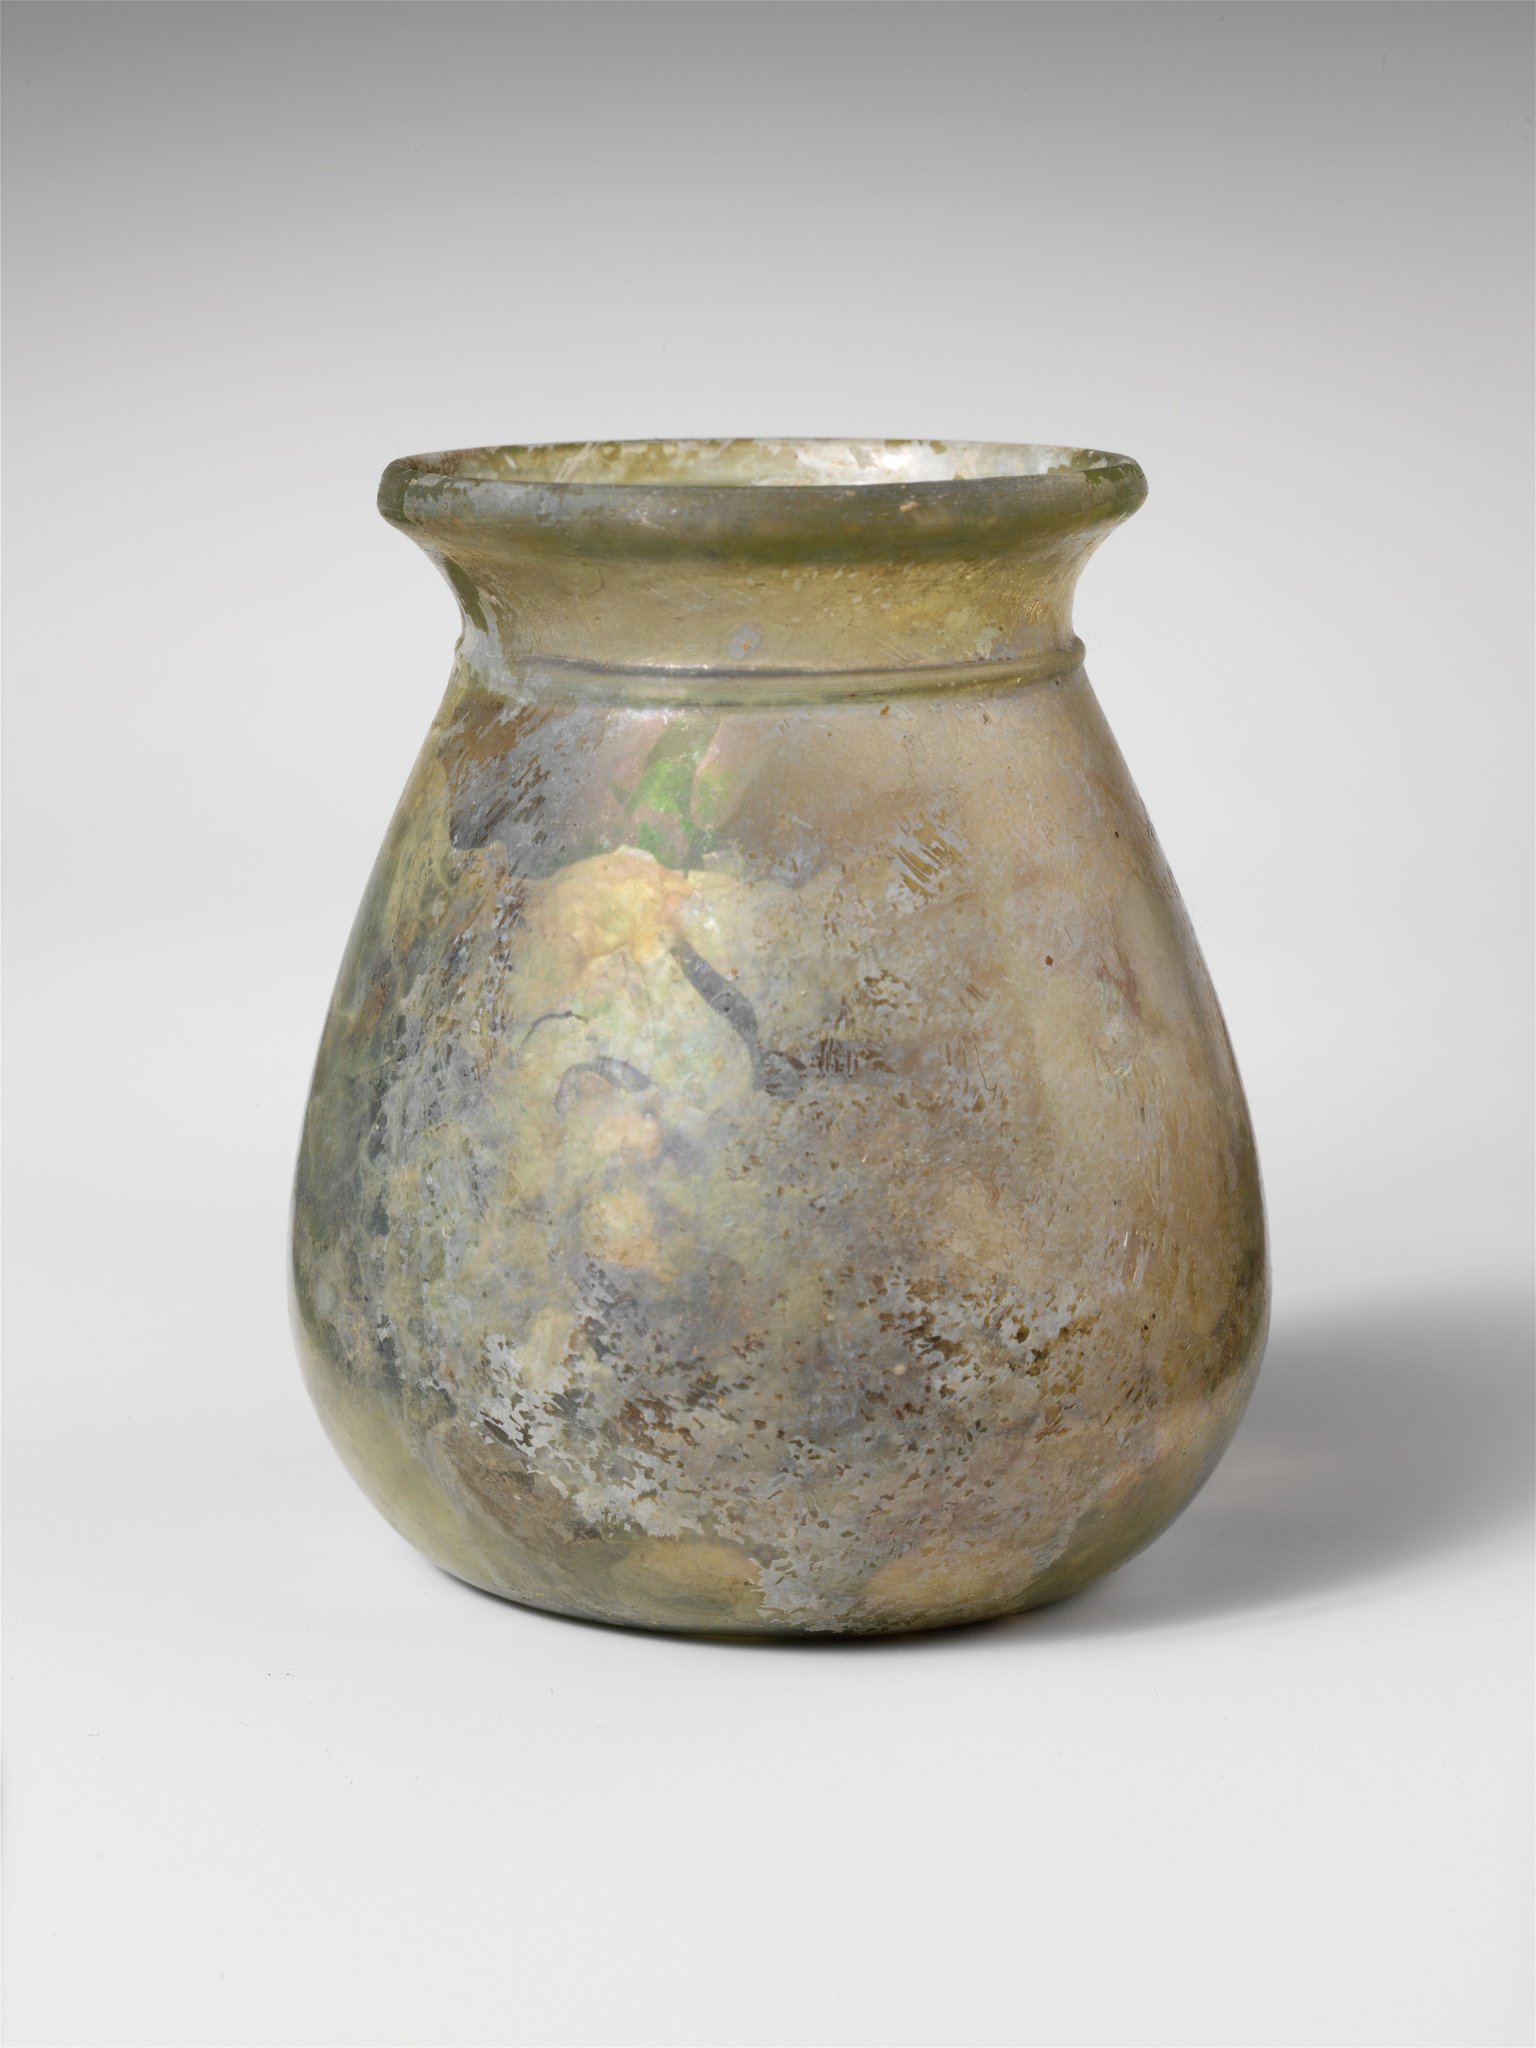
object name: jar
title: Glass jar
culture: roman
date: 201-400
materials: glass